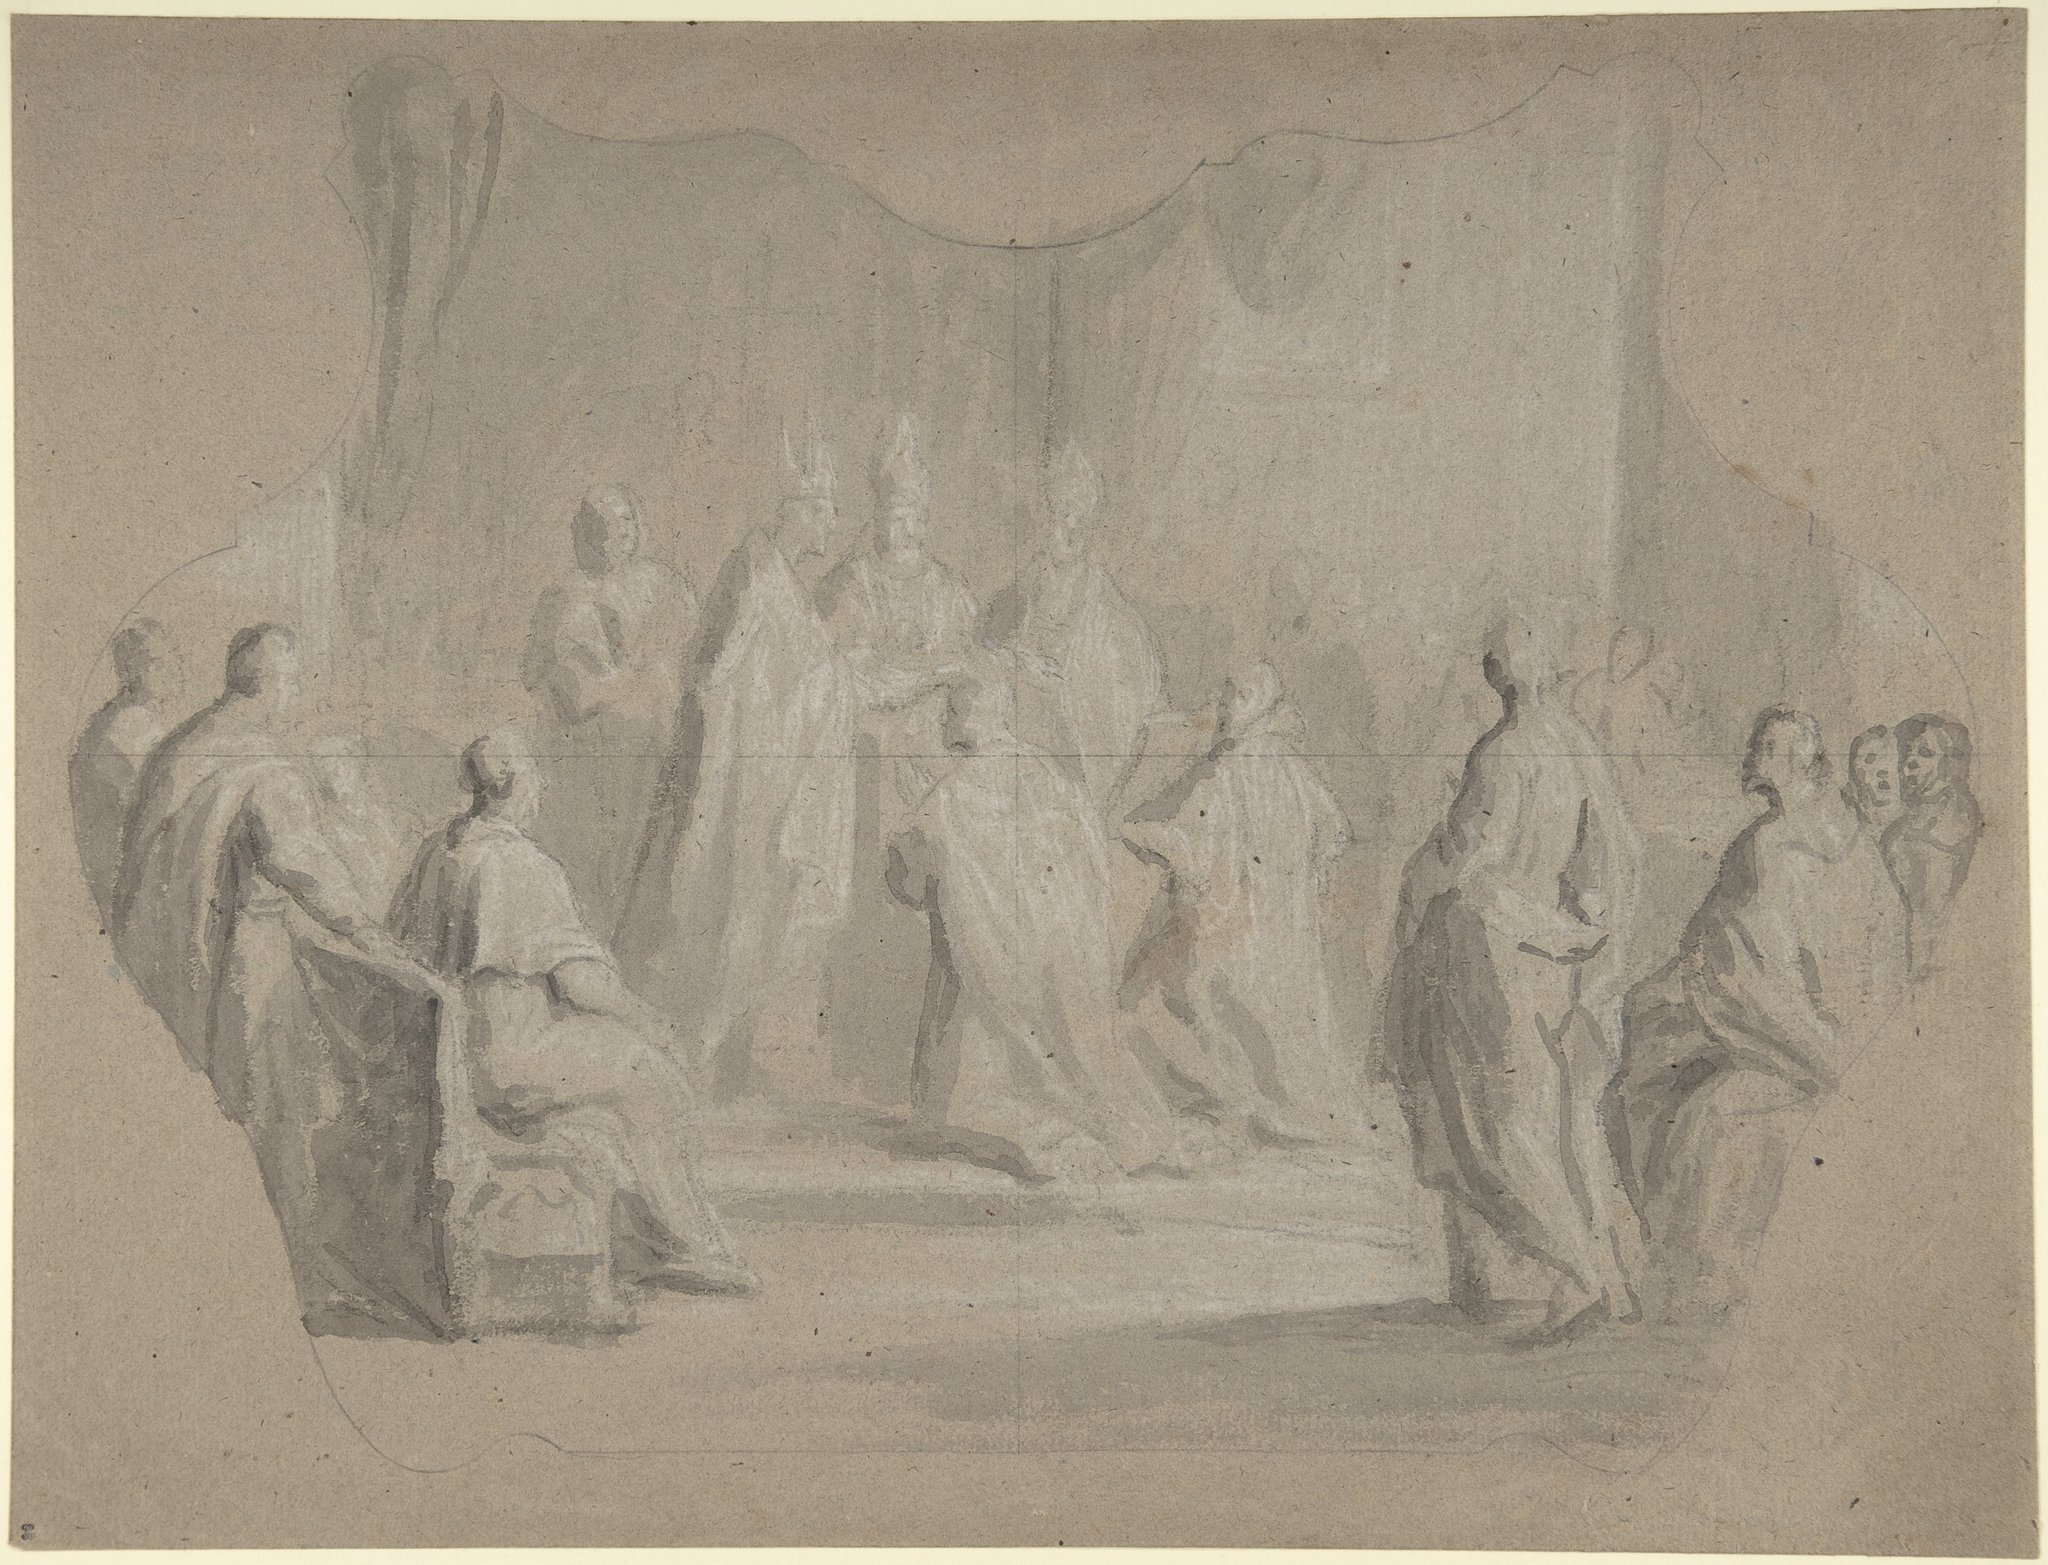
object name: drawing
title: The Consecration of a Bishop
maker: anonymous, french, 18th century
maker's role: artist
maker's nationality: french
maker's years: 1700-1800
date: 1701-1800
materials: chalk, graphite, paper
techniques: brush, heightening, wash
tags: men,bishops